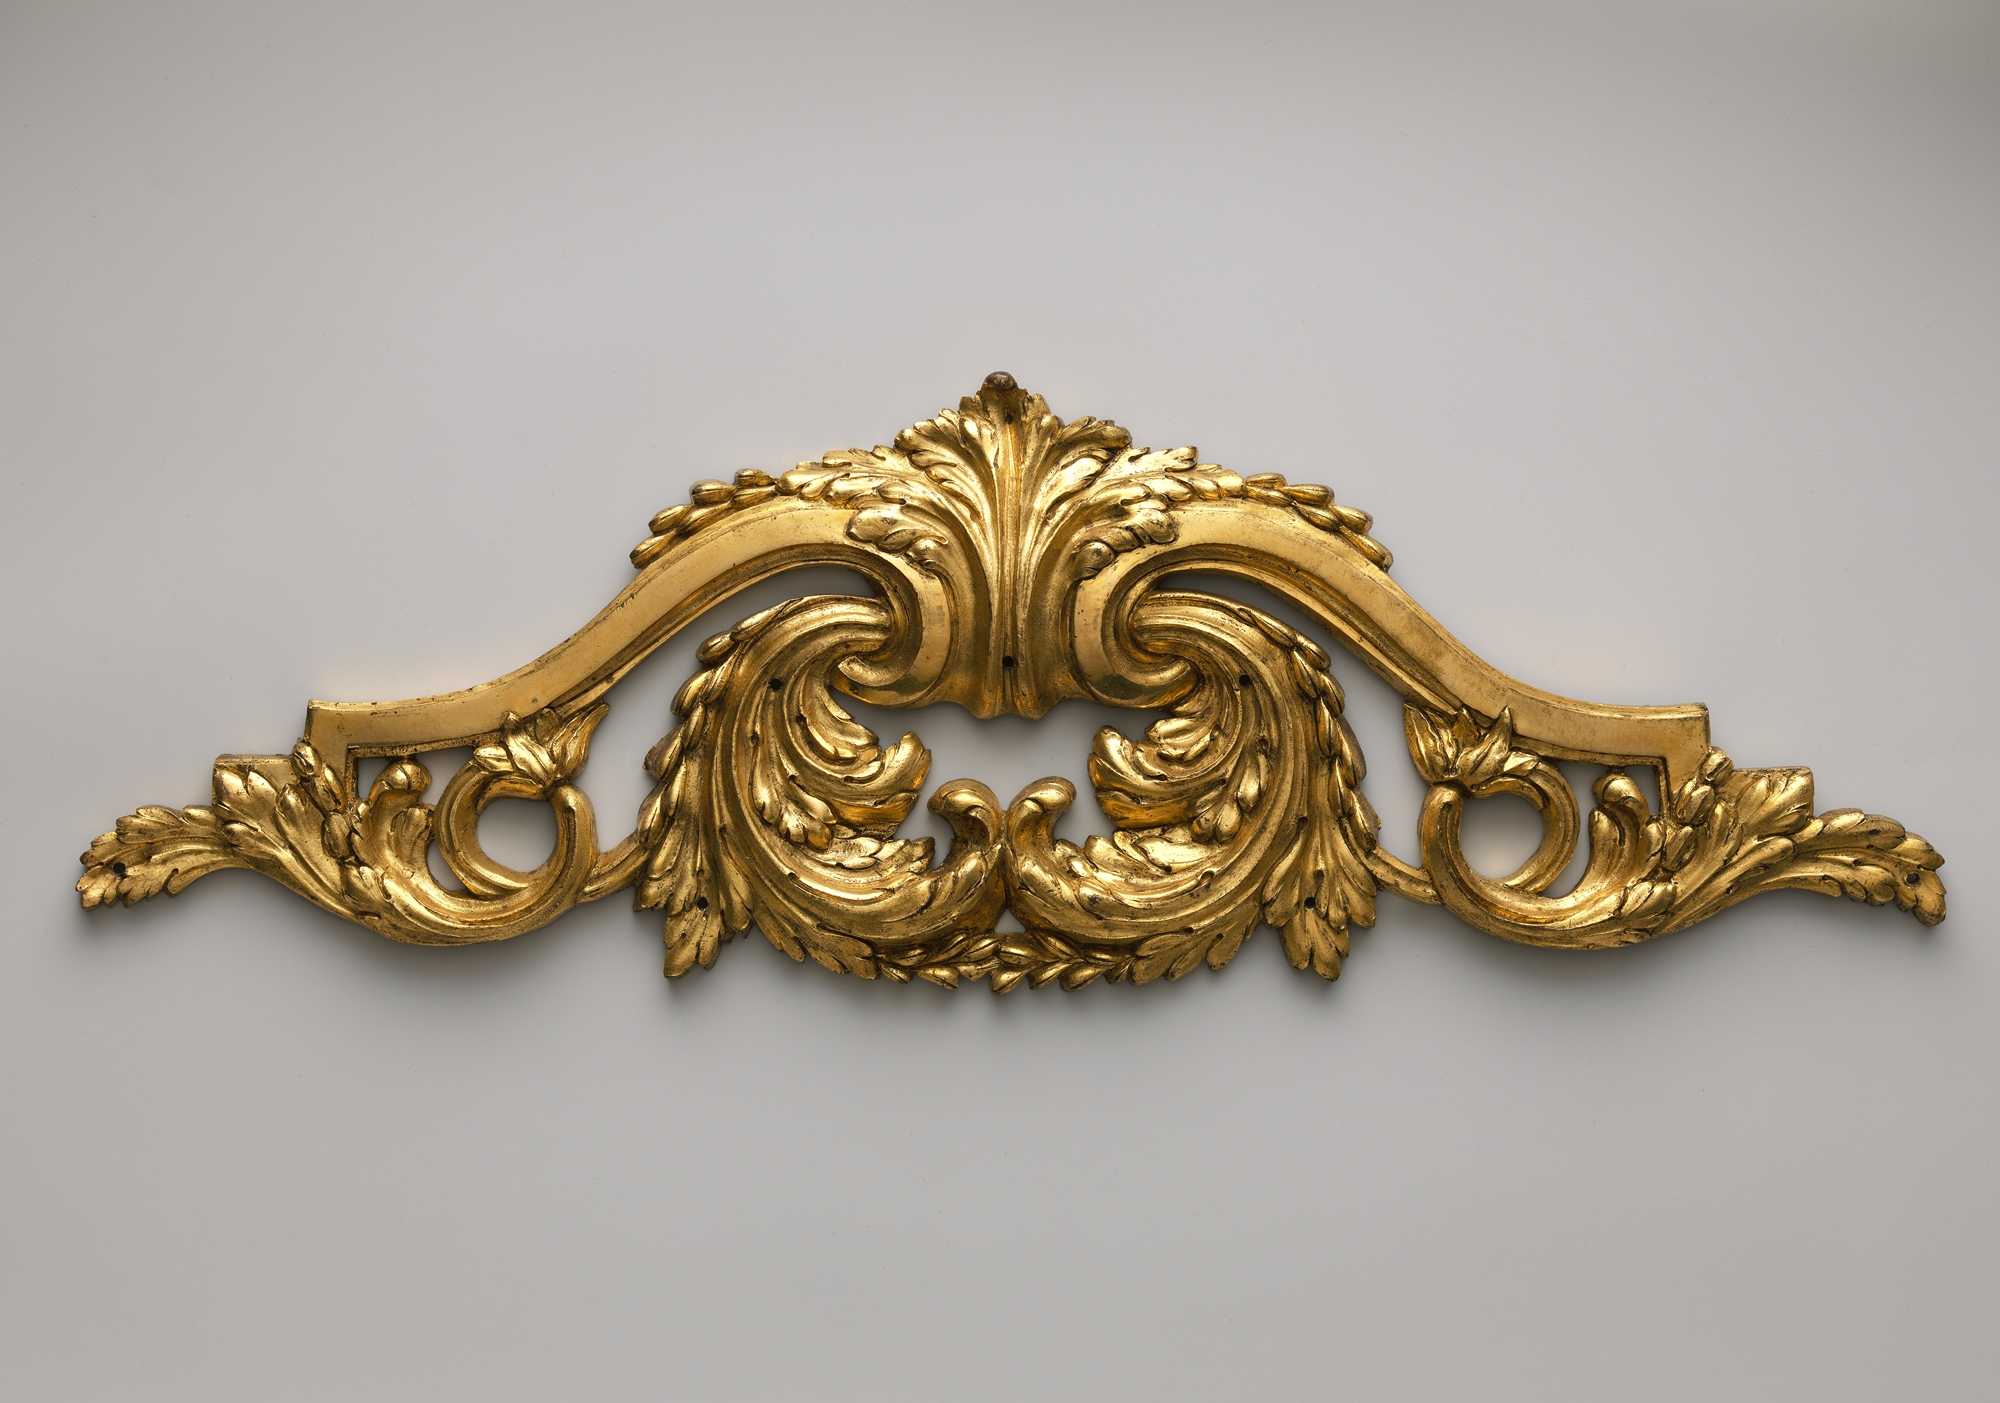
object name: apron ornament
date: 1801-1900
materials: gilt bronze